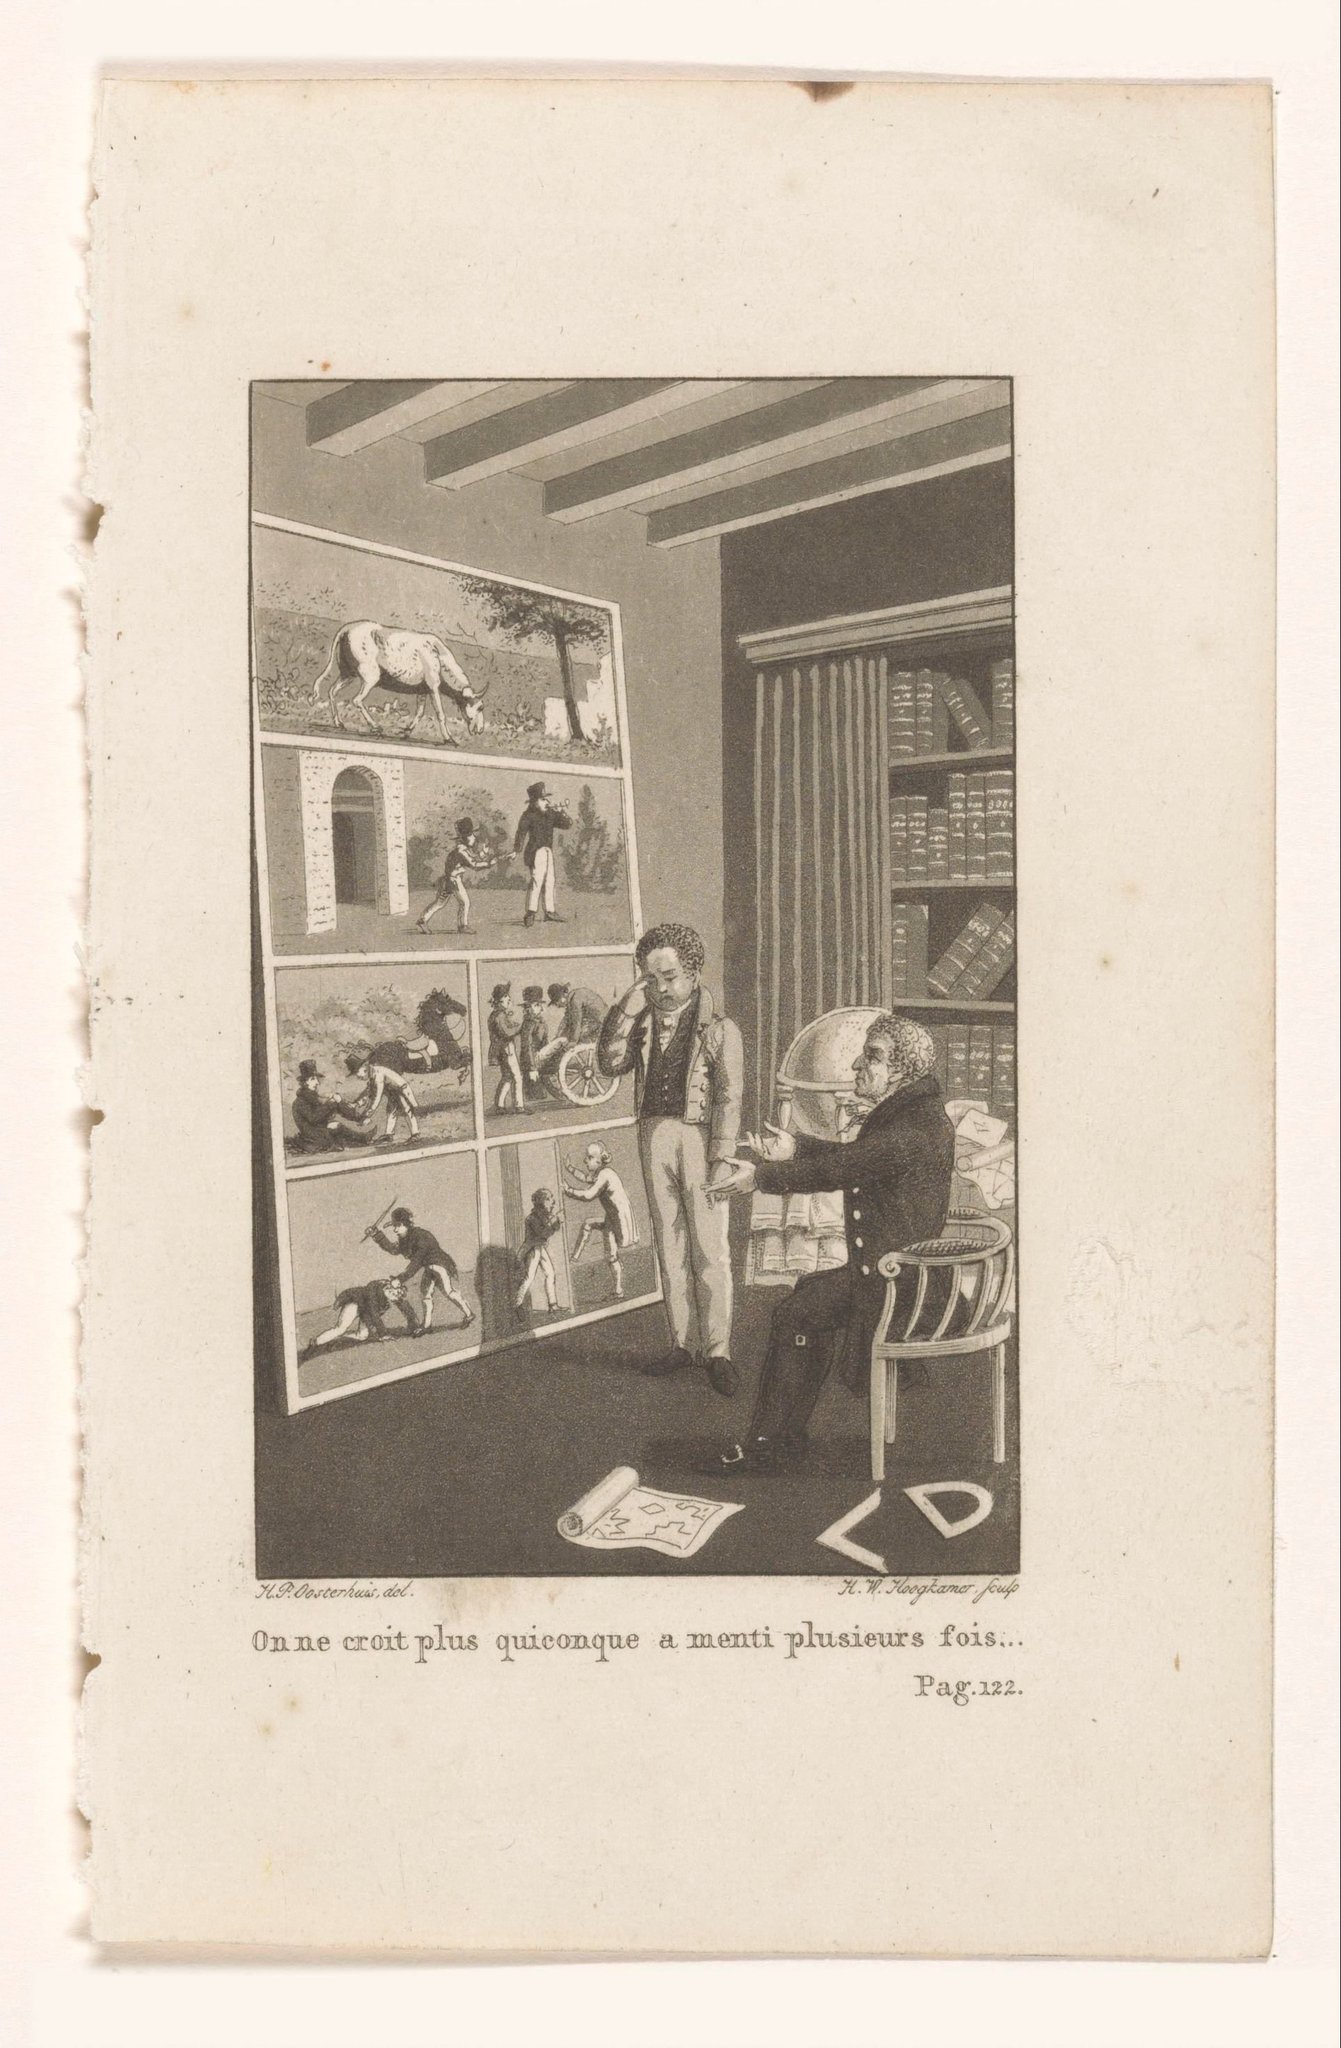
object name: print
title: Vader spreekt zijn zoon bestraffend toe in zijn studeerkamer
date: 1826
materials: paper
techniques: aquatint, etching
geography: amsterdam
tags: education, science and learning, study; 'studiolo'; library, globe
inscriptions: collector's mark: Lugt 4779, collector's mark: Lugt 2228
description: Illustratie van een moralistisch verhaal over een jongen genaamd Mensonger. Zijn vader, gezeten op een stoel in zijn studeerkamer, confronteert zijn zoon met alle misstanden die hij heeft begaan aan de hand van een levensgroot tableau.